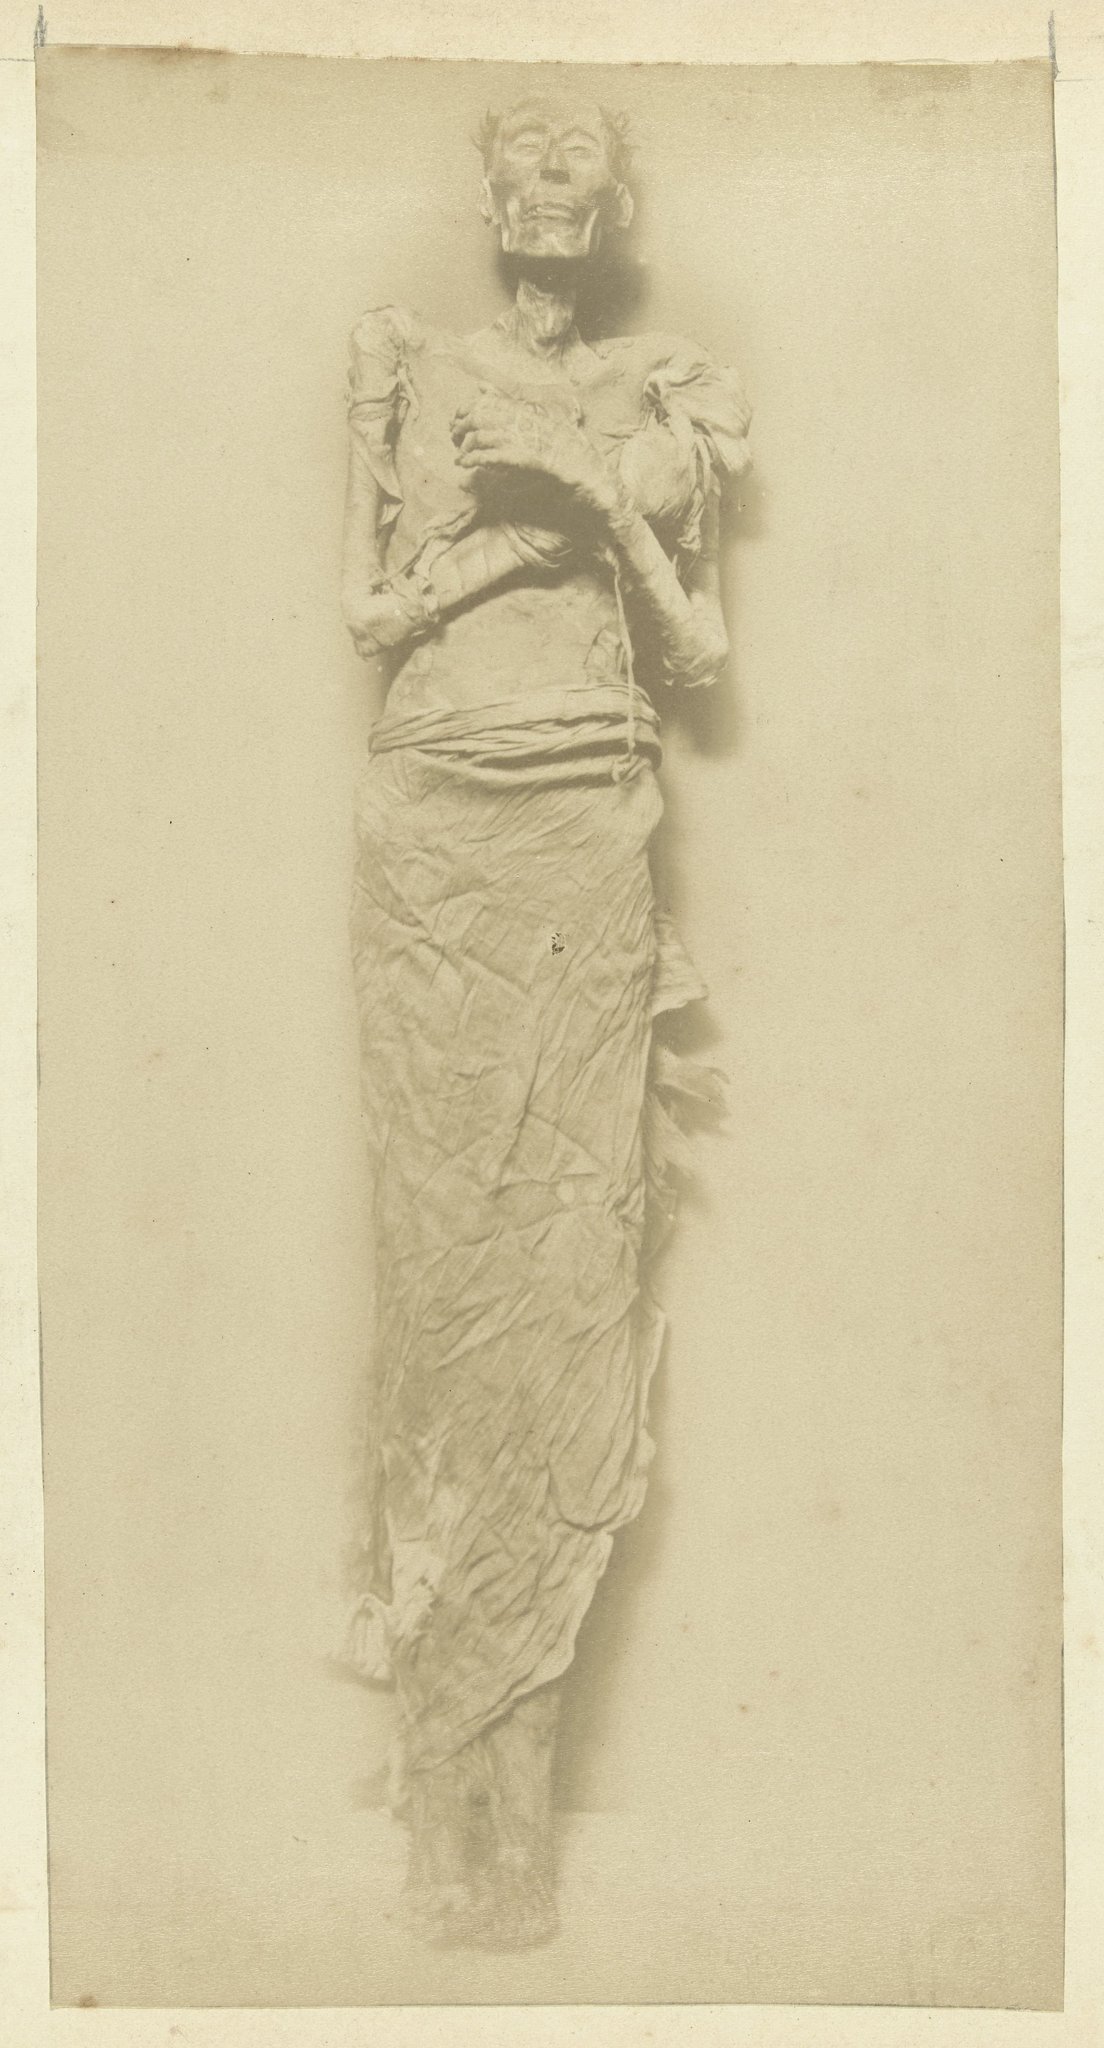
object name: photograph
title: Gemummificeerd lichaam van farao Ramses II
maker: Anonymous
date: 1860-1900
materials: paper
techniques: albumen print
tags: mummy